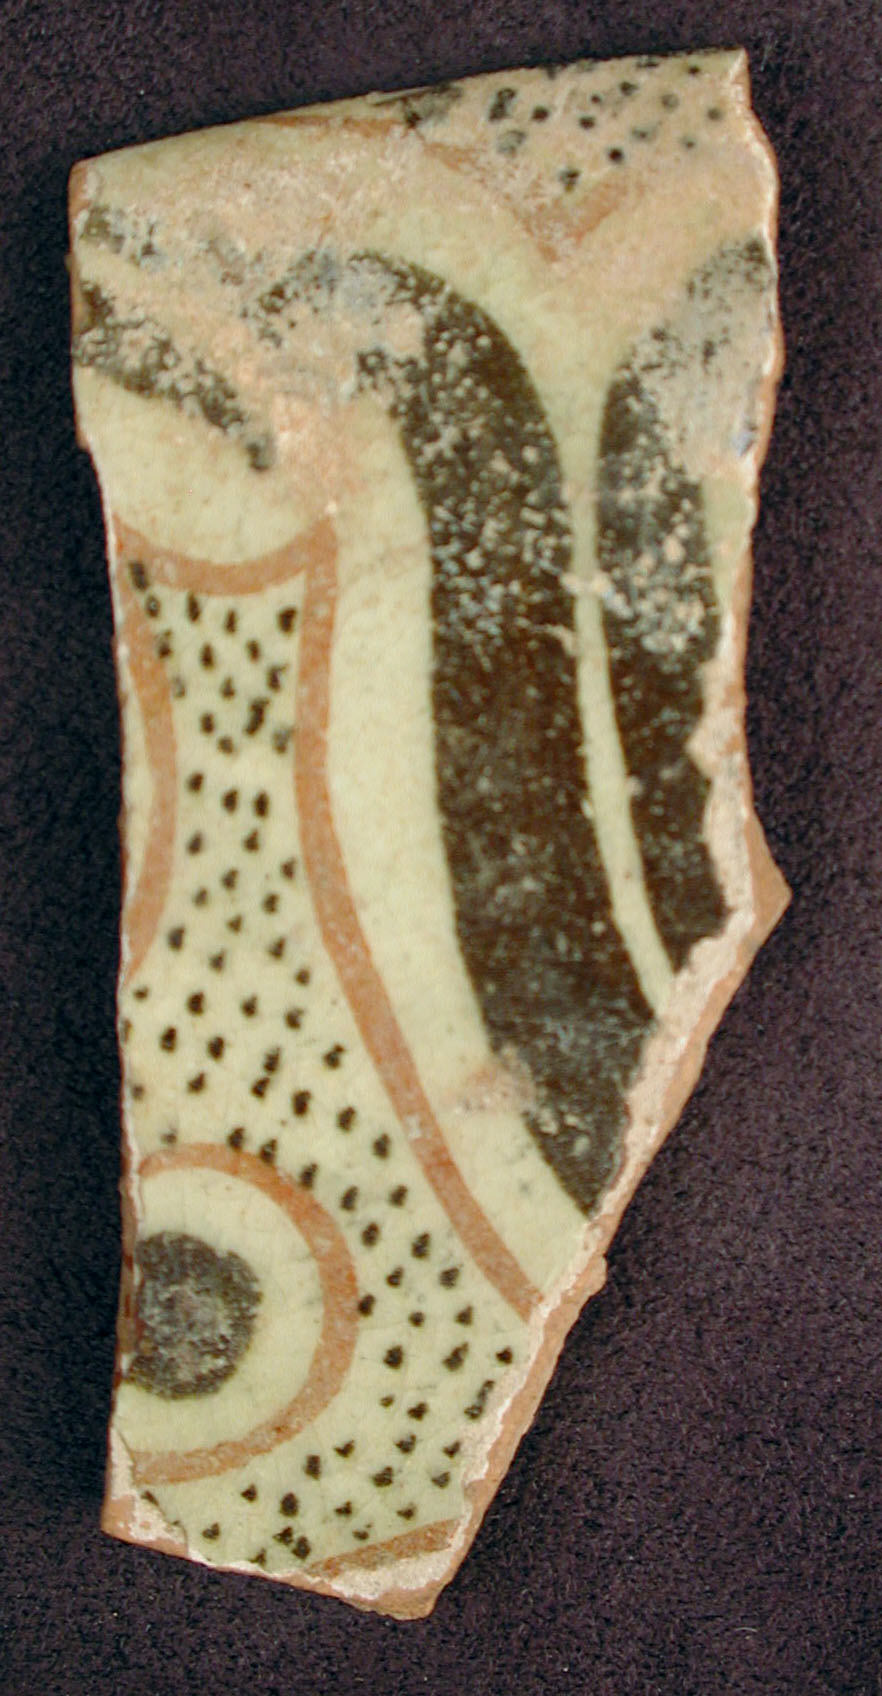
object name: fragment of a bowl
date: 901-1000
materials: earthenware, glaze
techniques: polychrome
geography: iran